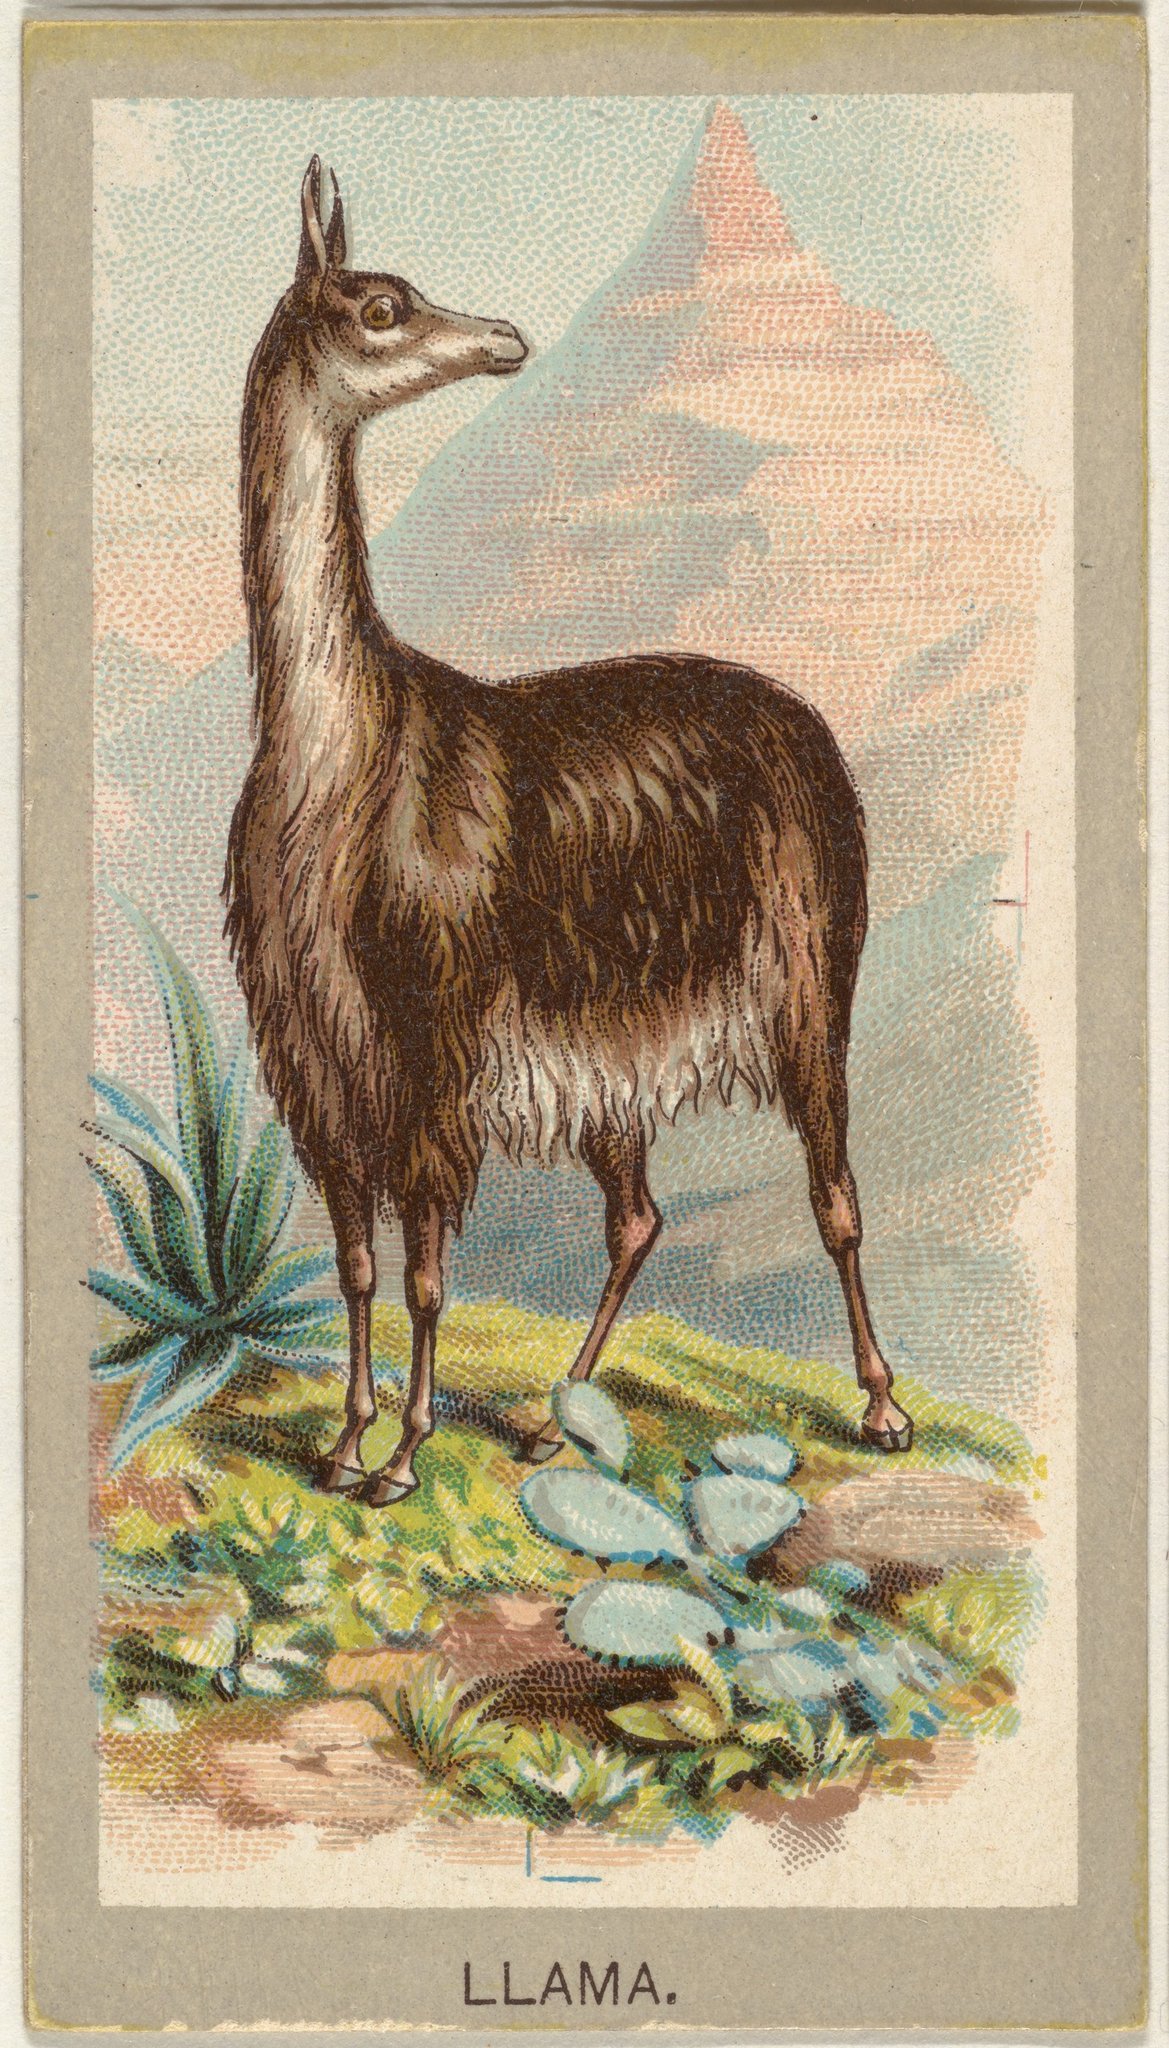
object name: print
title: Llama, from the Animals of the World series (T180), issued by Abdul Cigarettes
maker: abdul cigarettes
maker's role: publisher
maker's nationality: american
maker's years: 1881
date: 1881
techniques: color lithograph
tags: animals